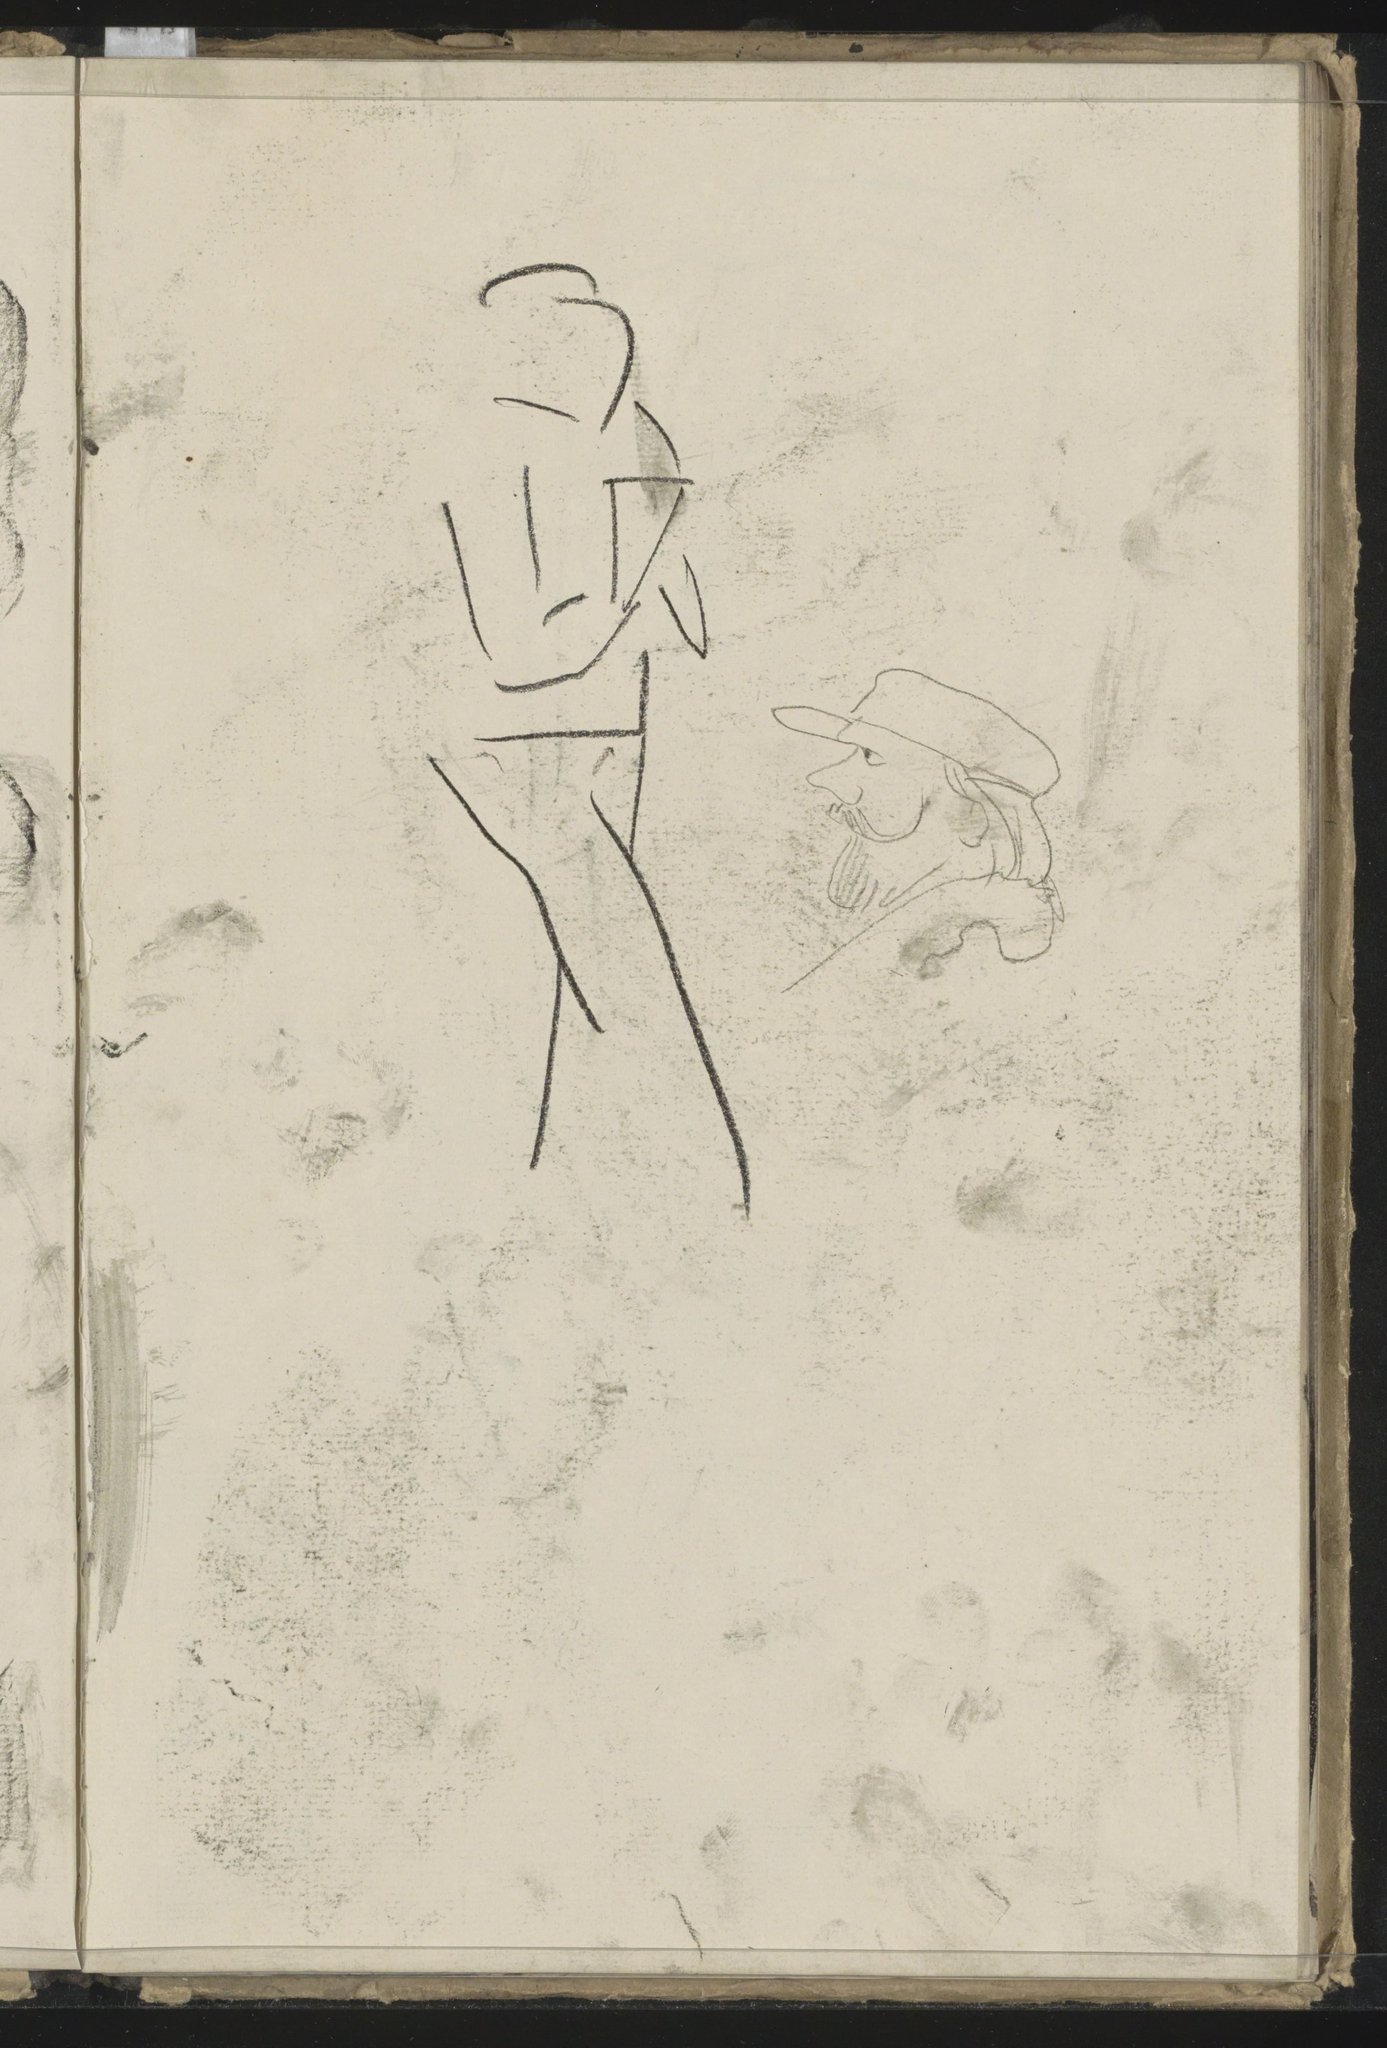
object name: sketchbook leaf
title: Mannenkop en een staande figuur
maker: carel adolph lion cachet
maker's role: draughtsman, print maker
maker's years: 1864-1945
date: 1890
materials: chalk, paper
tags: head (human), standing figure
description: Blad 5 recto uit een schetsboek met 38 bladen.